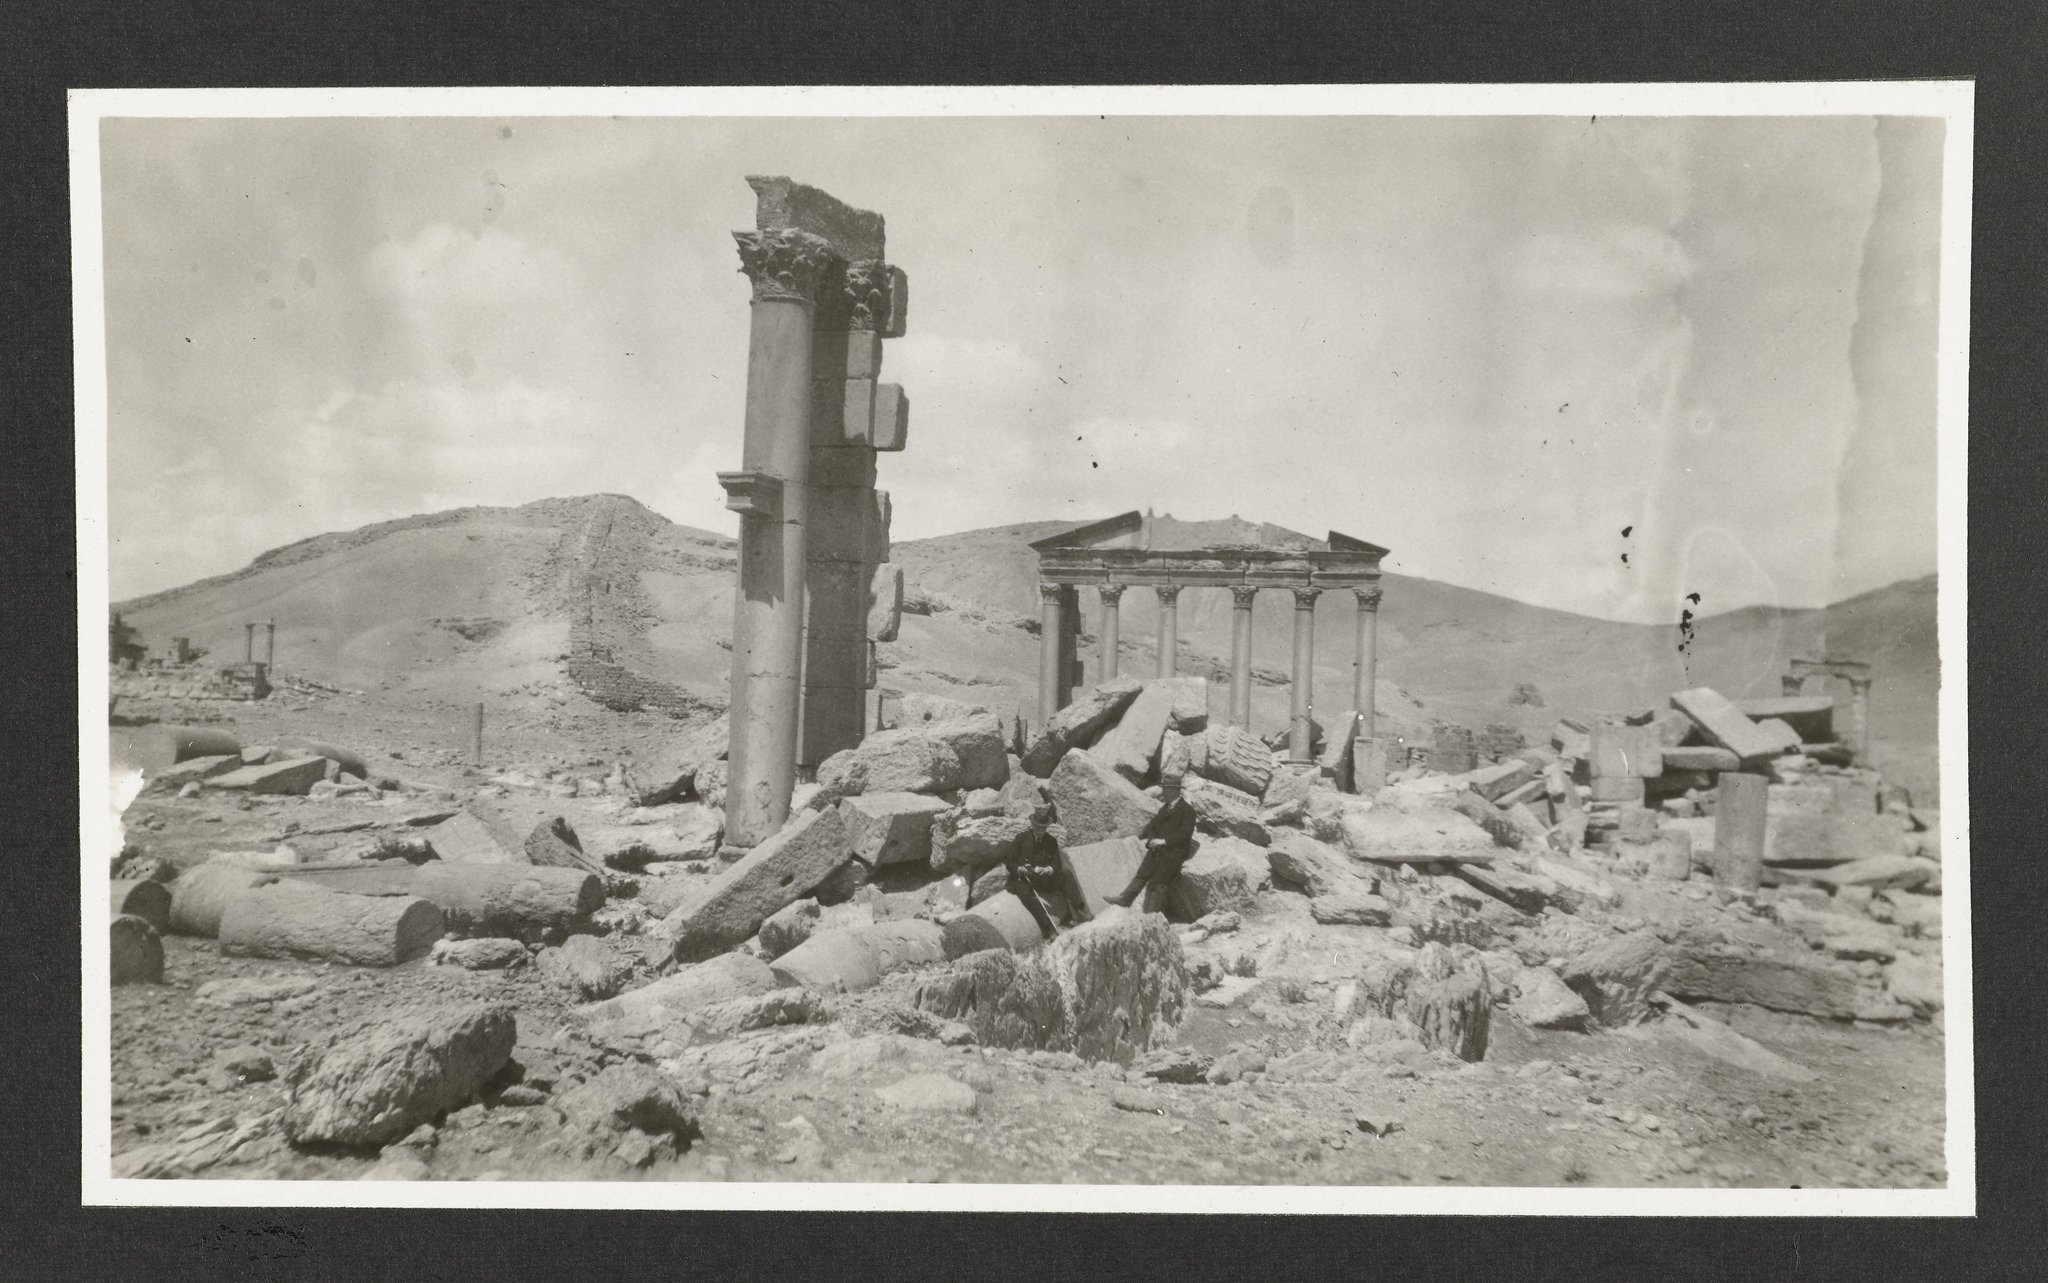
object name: photograph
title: Ruines van zuilen en tympaan.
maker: a.g.a. van eelde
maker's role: engineer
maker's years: 1862-1950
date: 1925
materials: cardboard, paper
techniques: gelatin silver print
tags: syrië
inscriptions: number: ‘3.’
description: Titel op object afkomstig uit inventaris (Verklaring der Photo's) behorend bij het album.